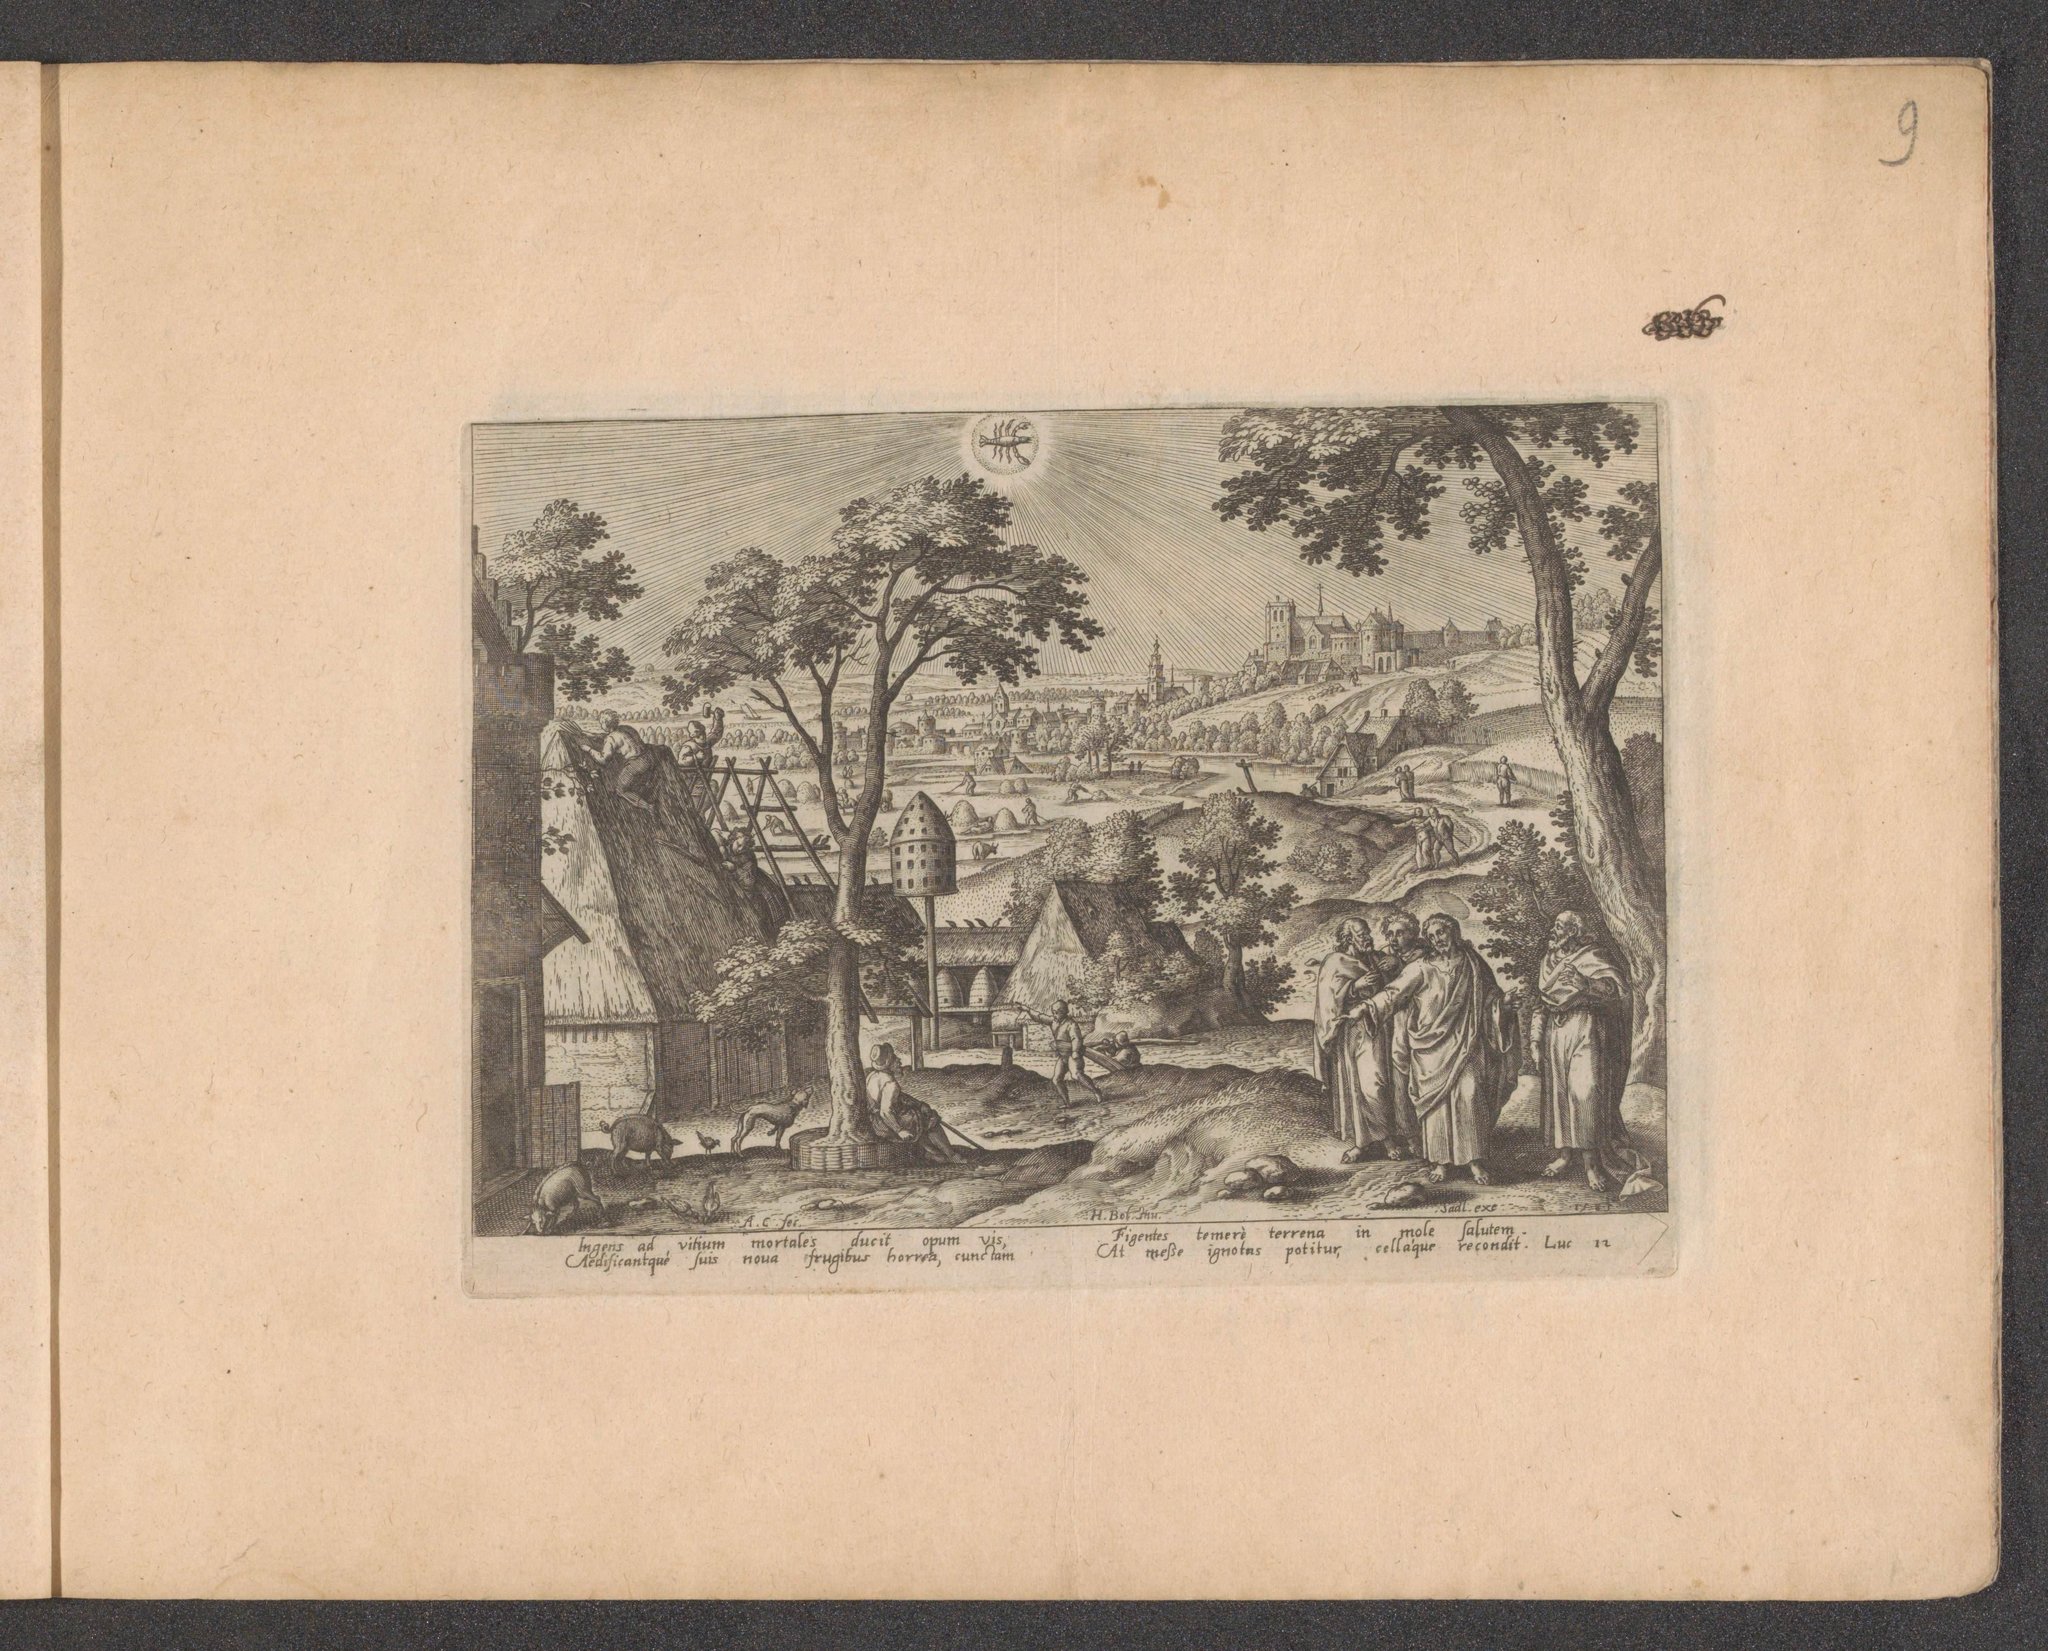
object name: album leaf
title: Juni: Christus leert de apostelen niet te veel waarde te hechten aan aardse goederen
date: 1585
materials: paper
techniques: engraving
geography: antwerp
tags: cancer (zodiacal sign of june), roof-covering, landscape symbolizing june, do not lay up earthly treasures ~ doctrine of christ on possessions (matthew 6:19; luke 12:21), dove-cote, bee-hive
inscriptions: date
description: Middenboven het teken van de dierenriem Kreeft. Op de voorgrond rechts staat Christus met drie apostelen die hij leert niet te veel waarde te hechten aan aardse goederen. Links een oude man, zittend onder een boom en een paar zwijnen voor een boerderij. Dakdekkers zijn bezig het rieten dak aan te leggen.